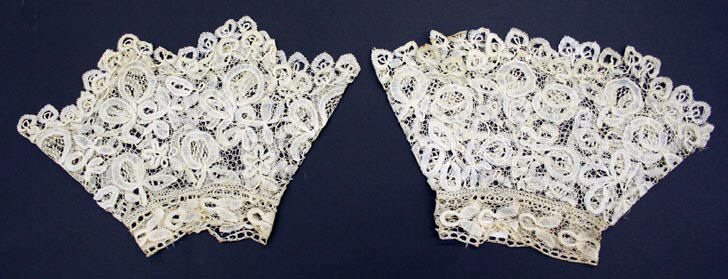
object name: cuff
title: Cuffs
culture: british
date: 1767-1800